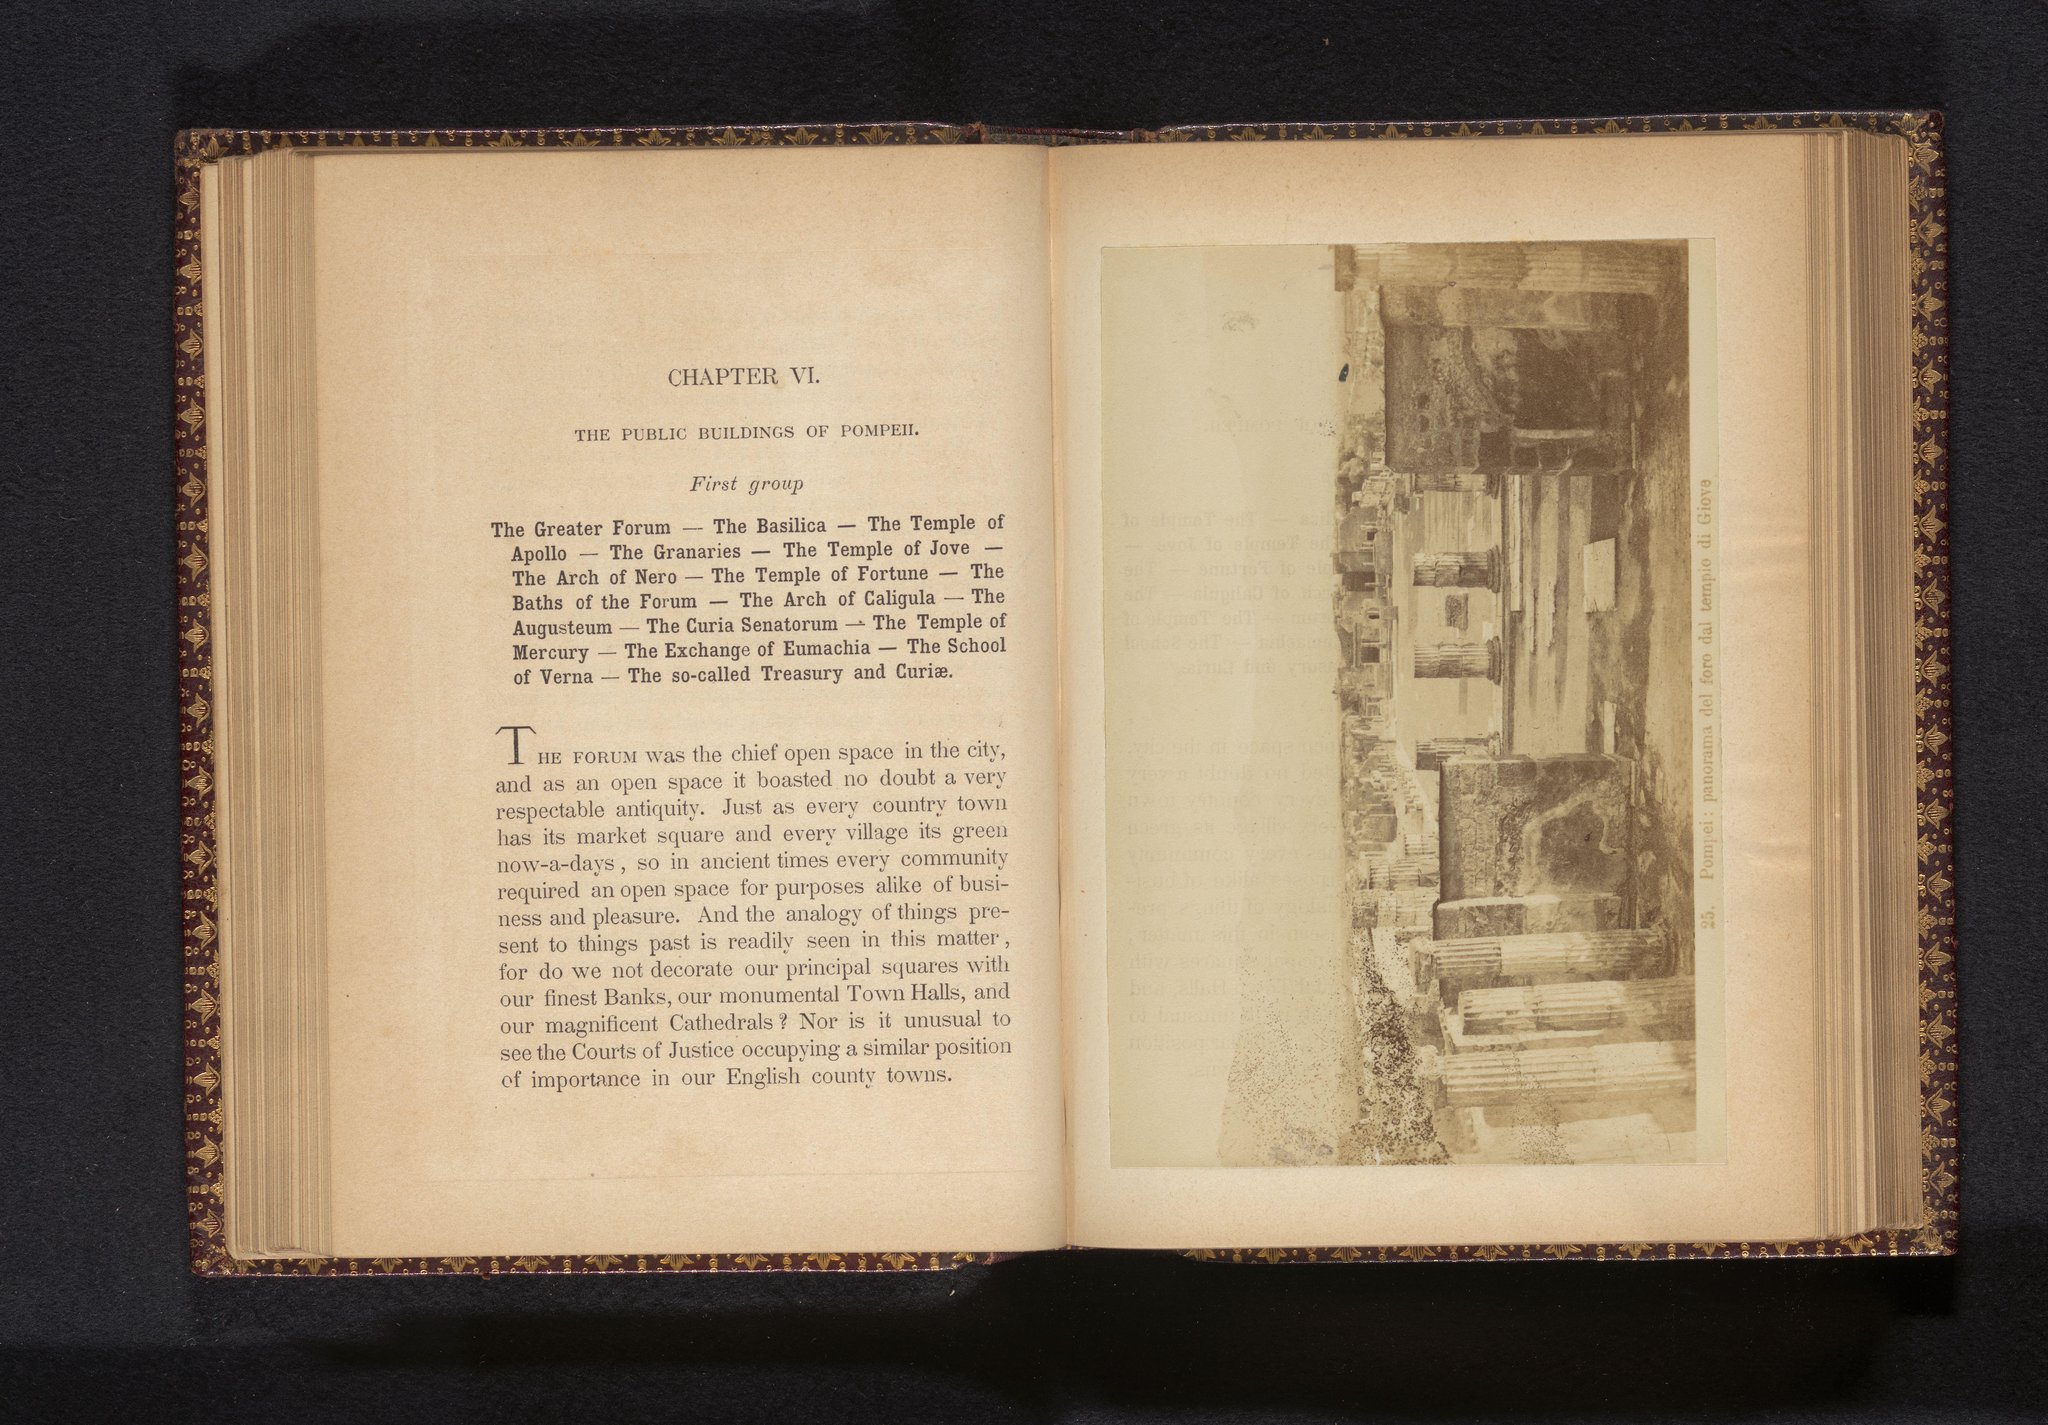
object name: page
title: Gezicht op het Foro Civile te Pompeï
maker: Anonymous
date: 1878-1888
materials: photographic support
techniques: albumen print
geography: pompeii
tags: landscape with ruins, market